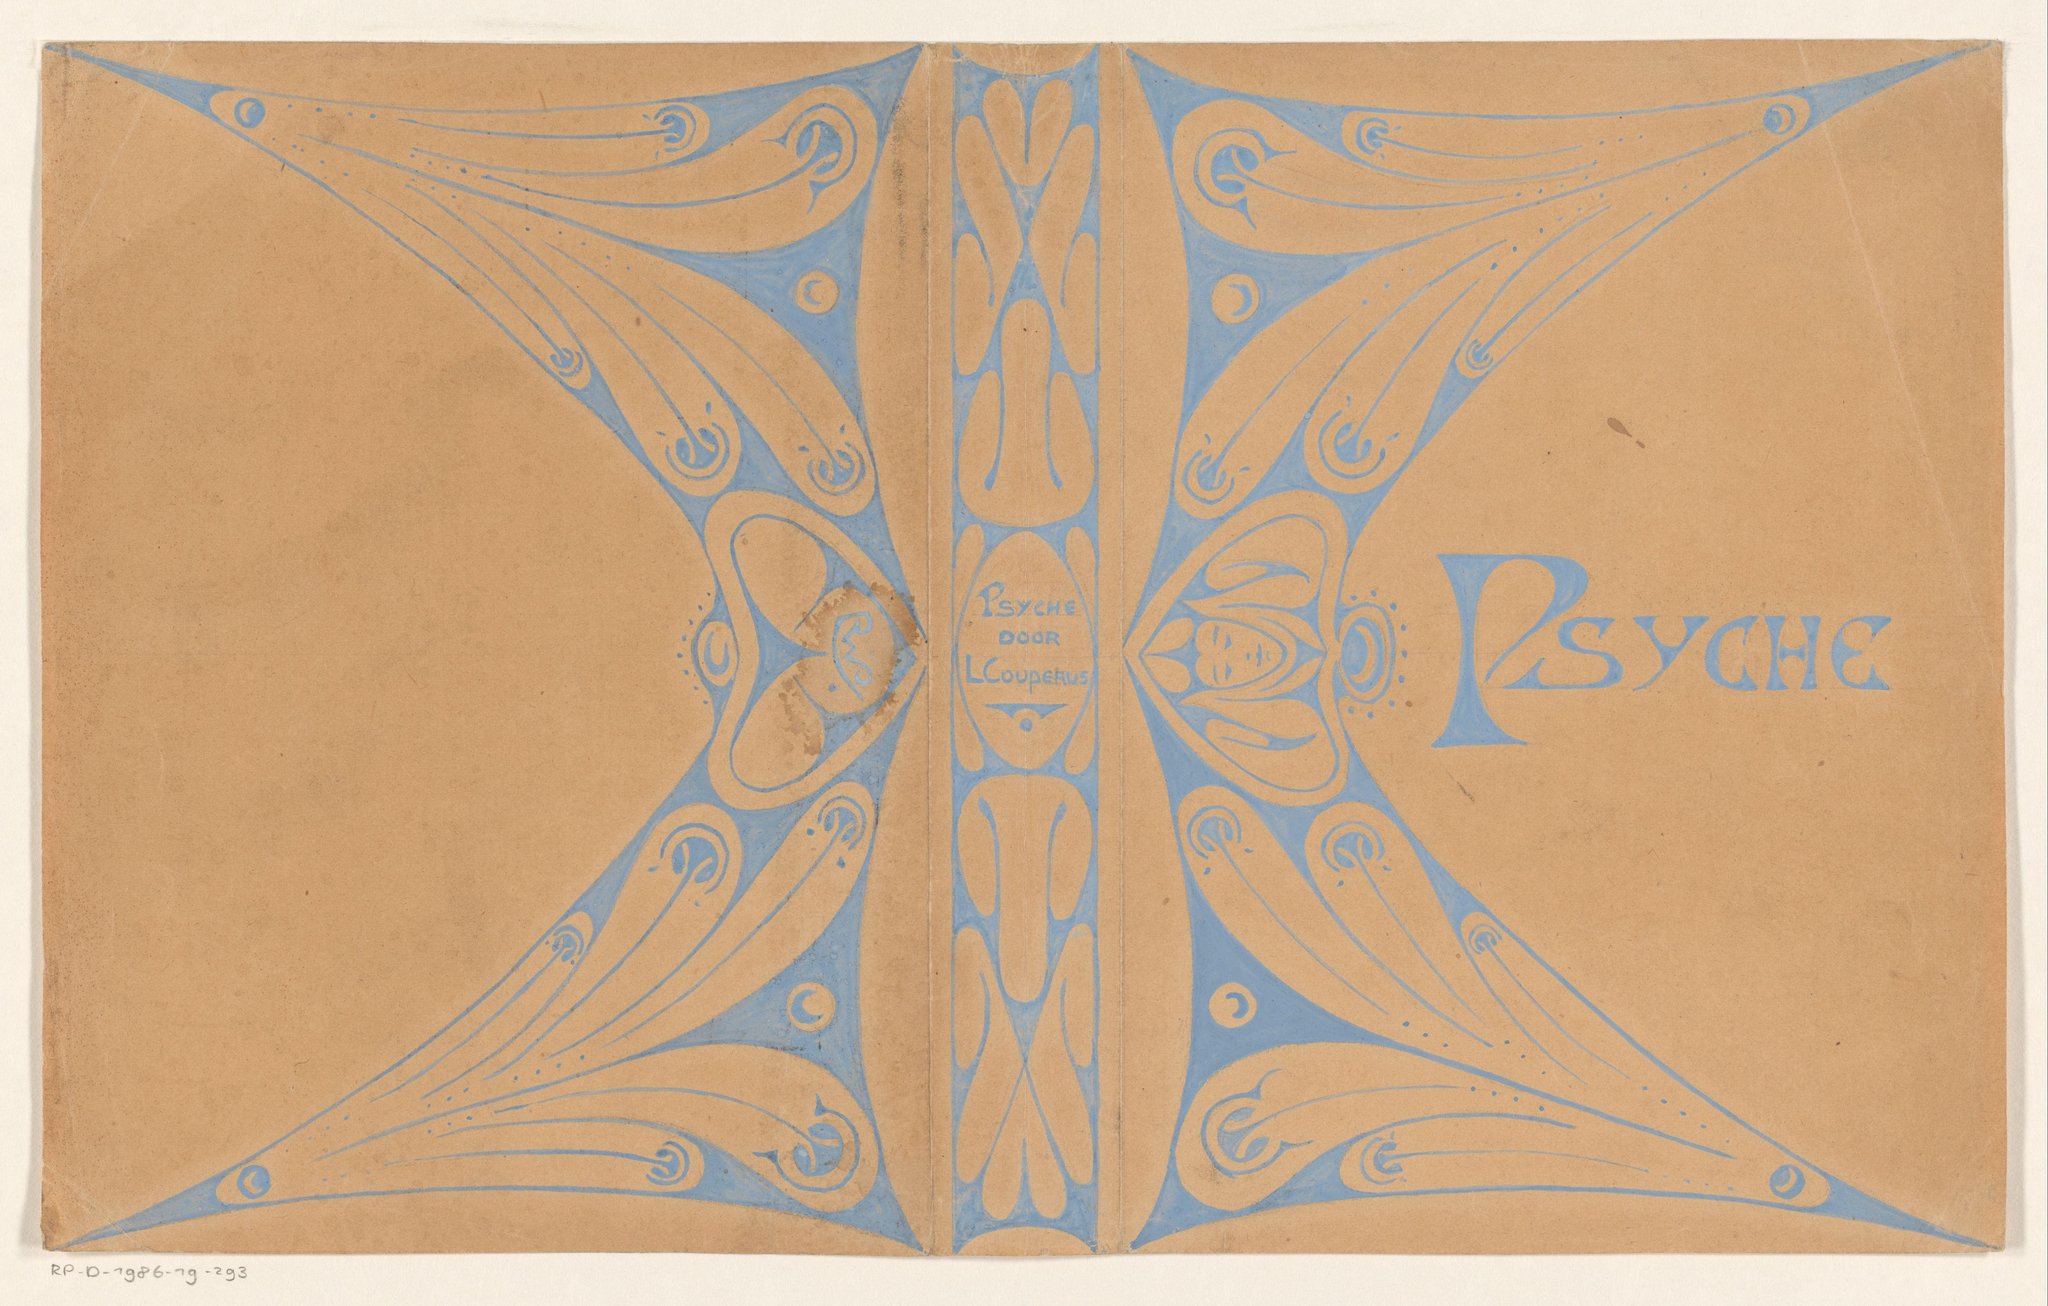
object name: study for binding design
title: Bandontwerp voor: Louis Couperus, Psyche, 1898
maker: reinier willem petrus de vries (1874-1953)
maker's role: draughtsman, print maker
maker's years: 1874-1953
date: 1898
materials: paint, paper, pencil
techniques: brush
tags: ornaments ~ art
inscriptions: number: ‘26.’, collector's mark: ‘R:MVS.’